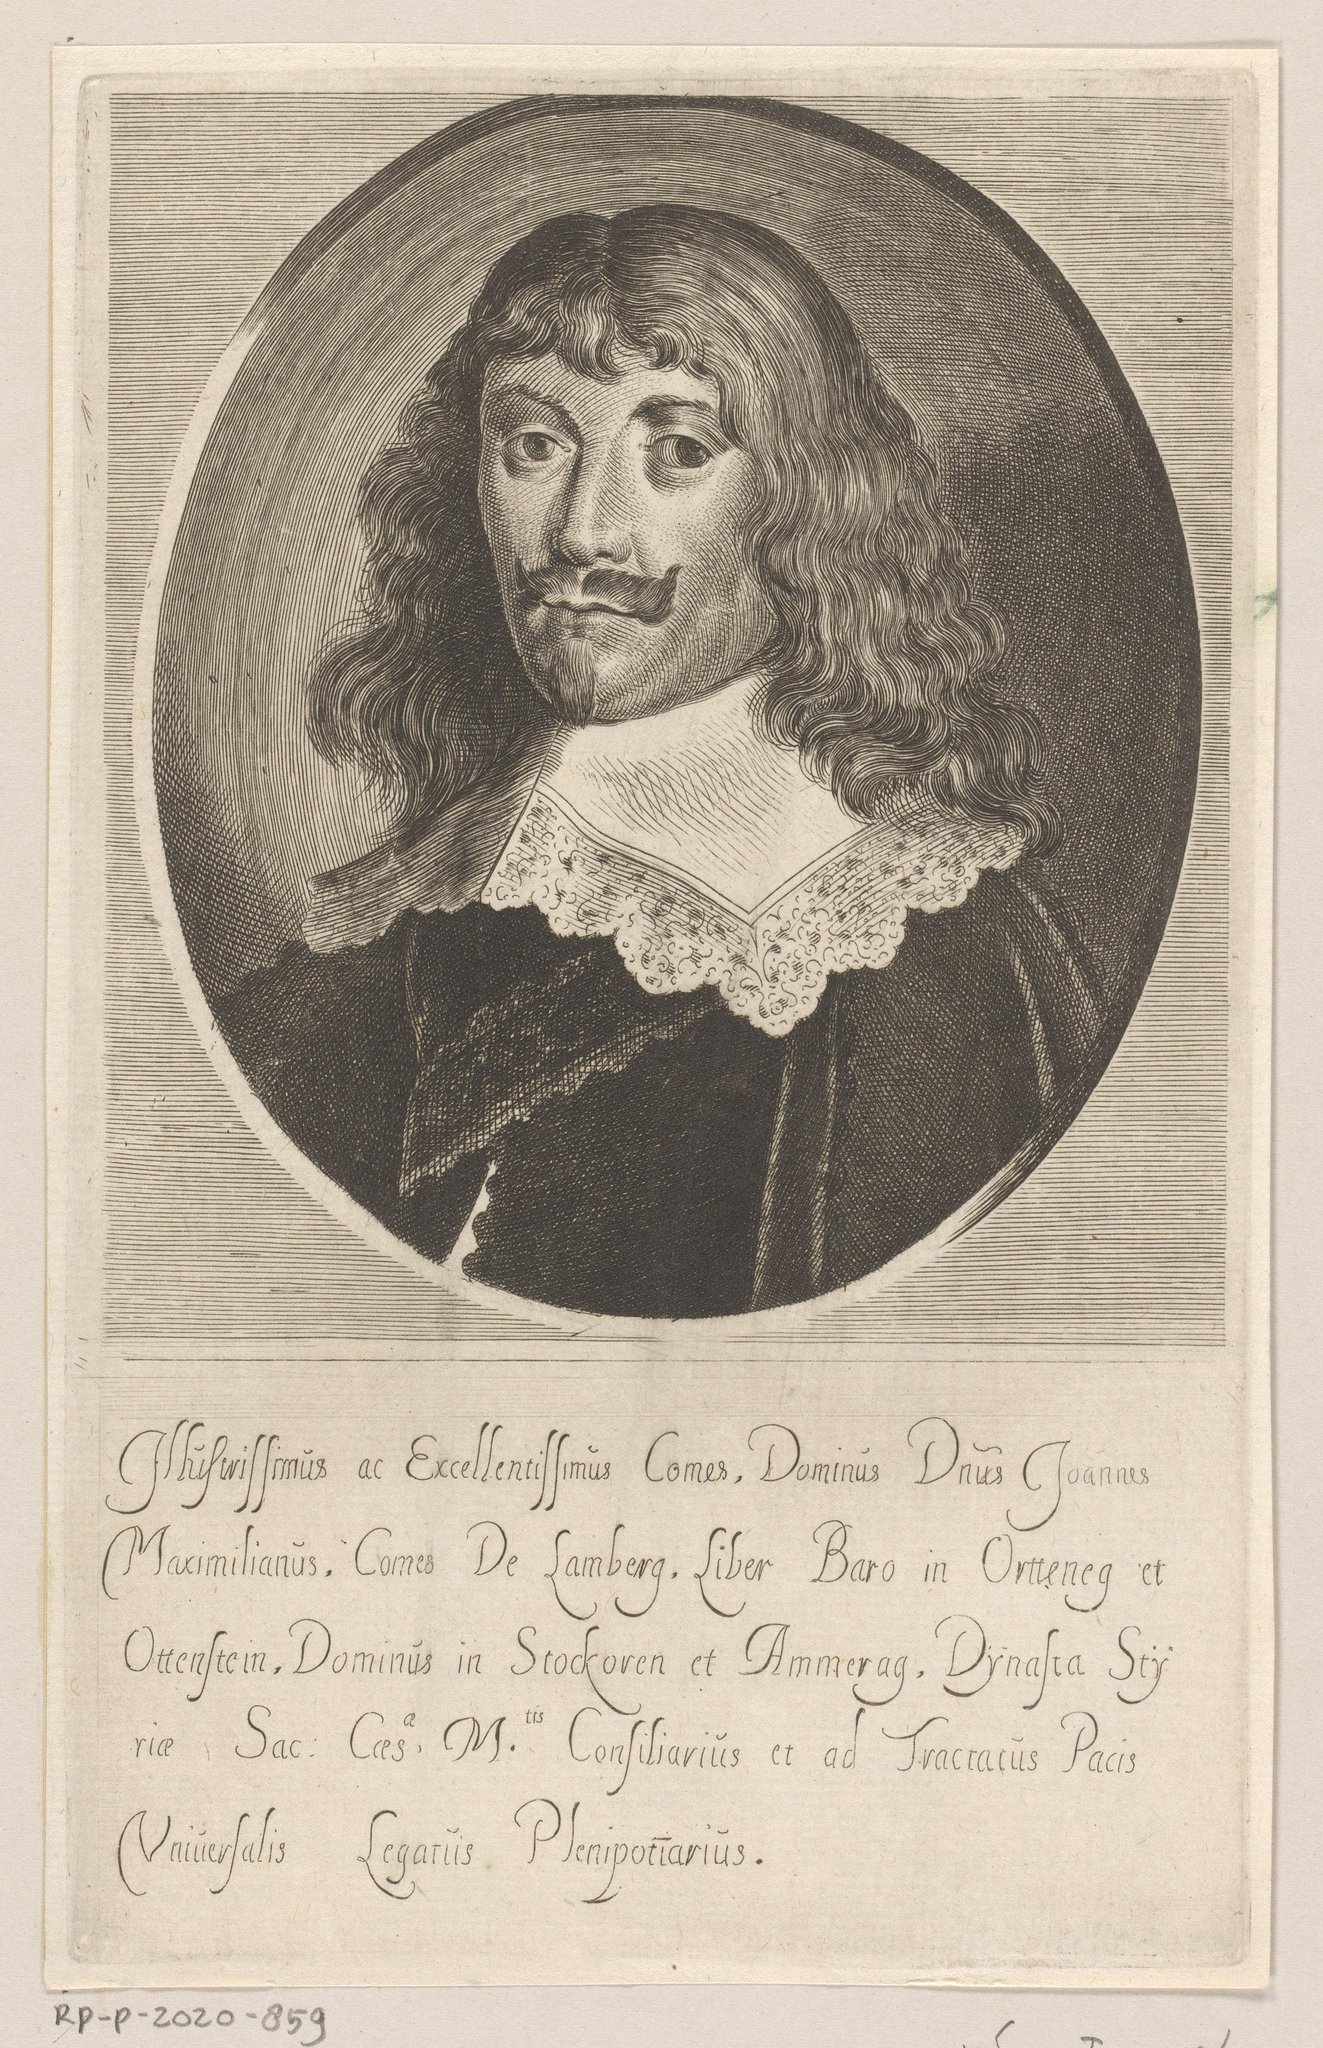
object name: print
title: Portretten van diplomaten en onderhandelaars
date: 1644-1646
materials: paper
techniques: engraving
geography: amsterdam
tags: historical persons, diplomacy, diplomat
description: Prent maakt deel uit van een serie van 43 prenten. Latere staat van prent gebruikt in de serie 'Pacificatores orbis Christiani in Westphaliam missi anno 1641', uitgegeven door Rombout van den Hoeye in Amsterdam.